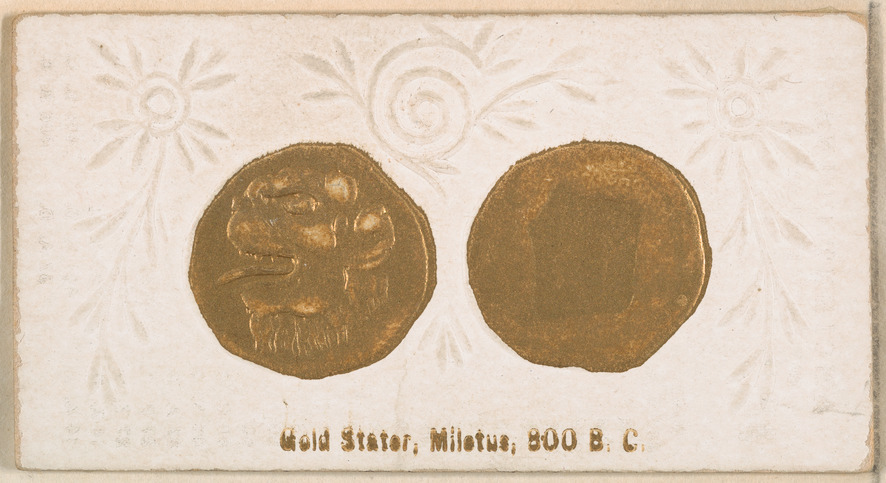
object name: print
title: Gold Stater, Miletus, 800 B.C., from the Ancient Coins series (N180) issued by Wm. S. Kimball & Co.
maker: william s. kimball & company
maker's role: publisher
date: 1888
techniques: color lithograph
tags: coins